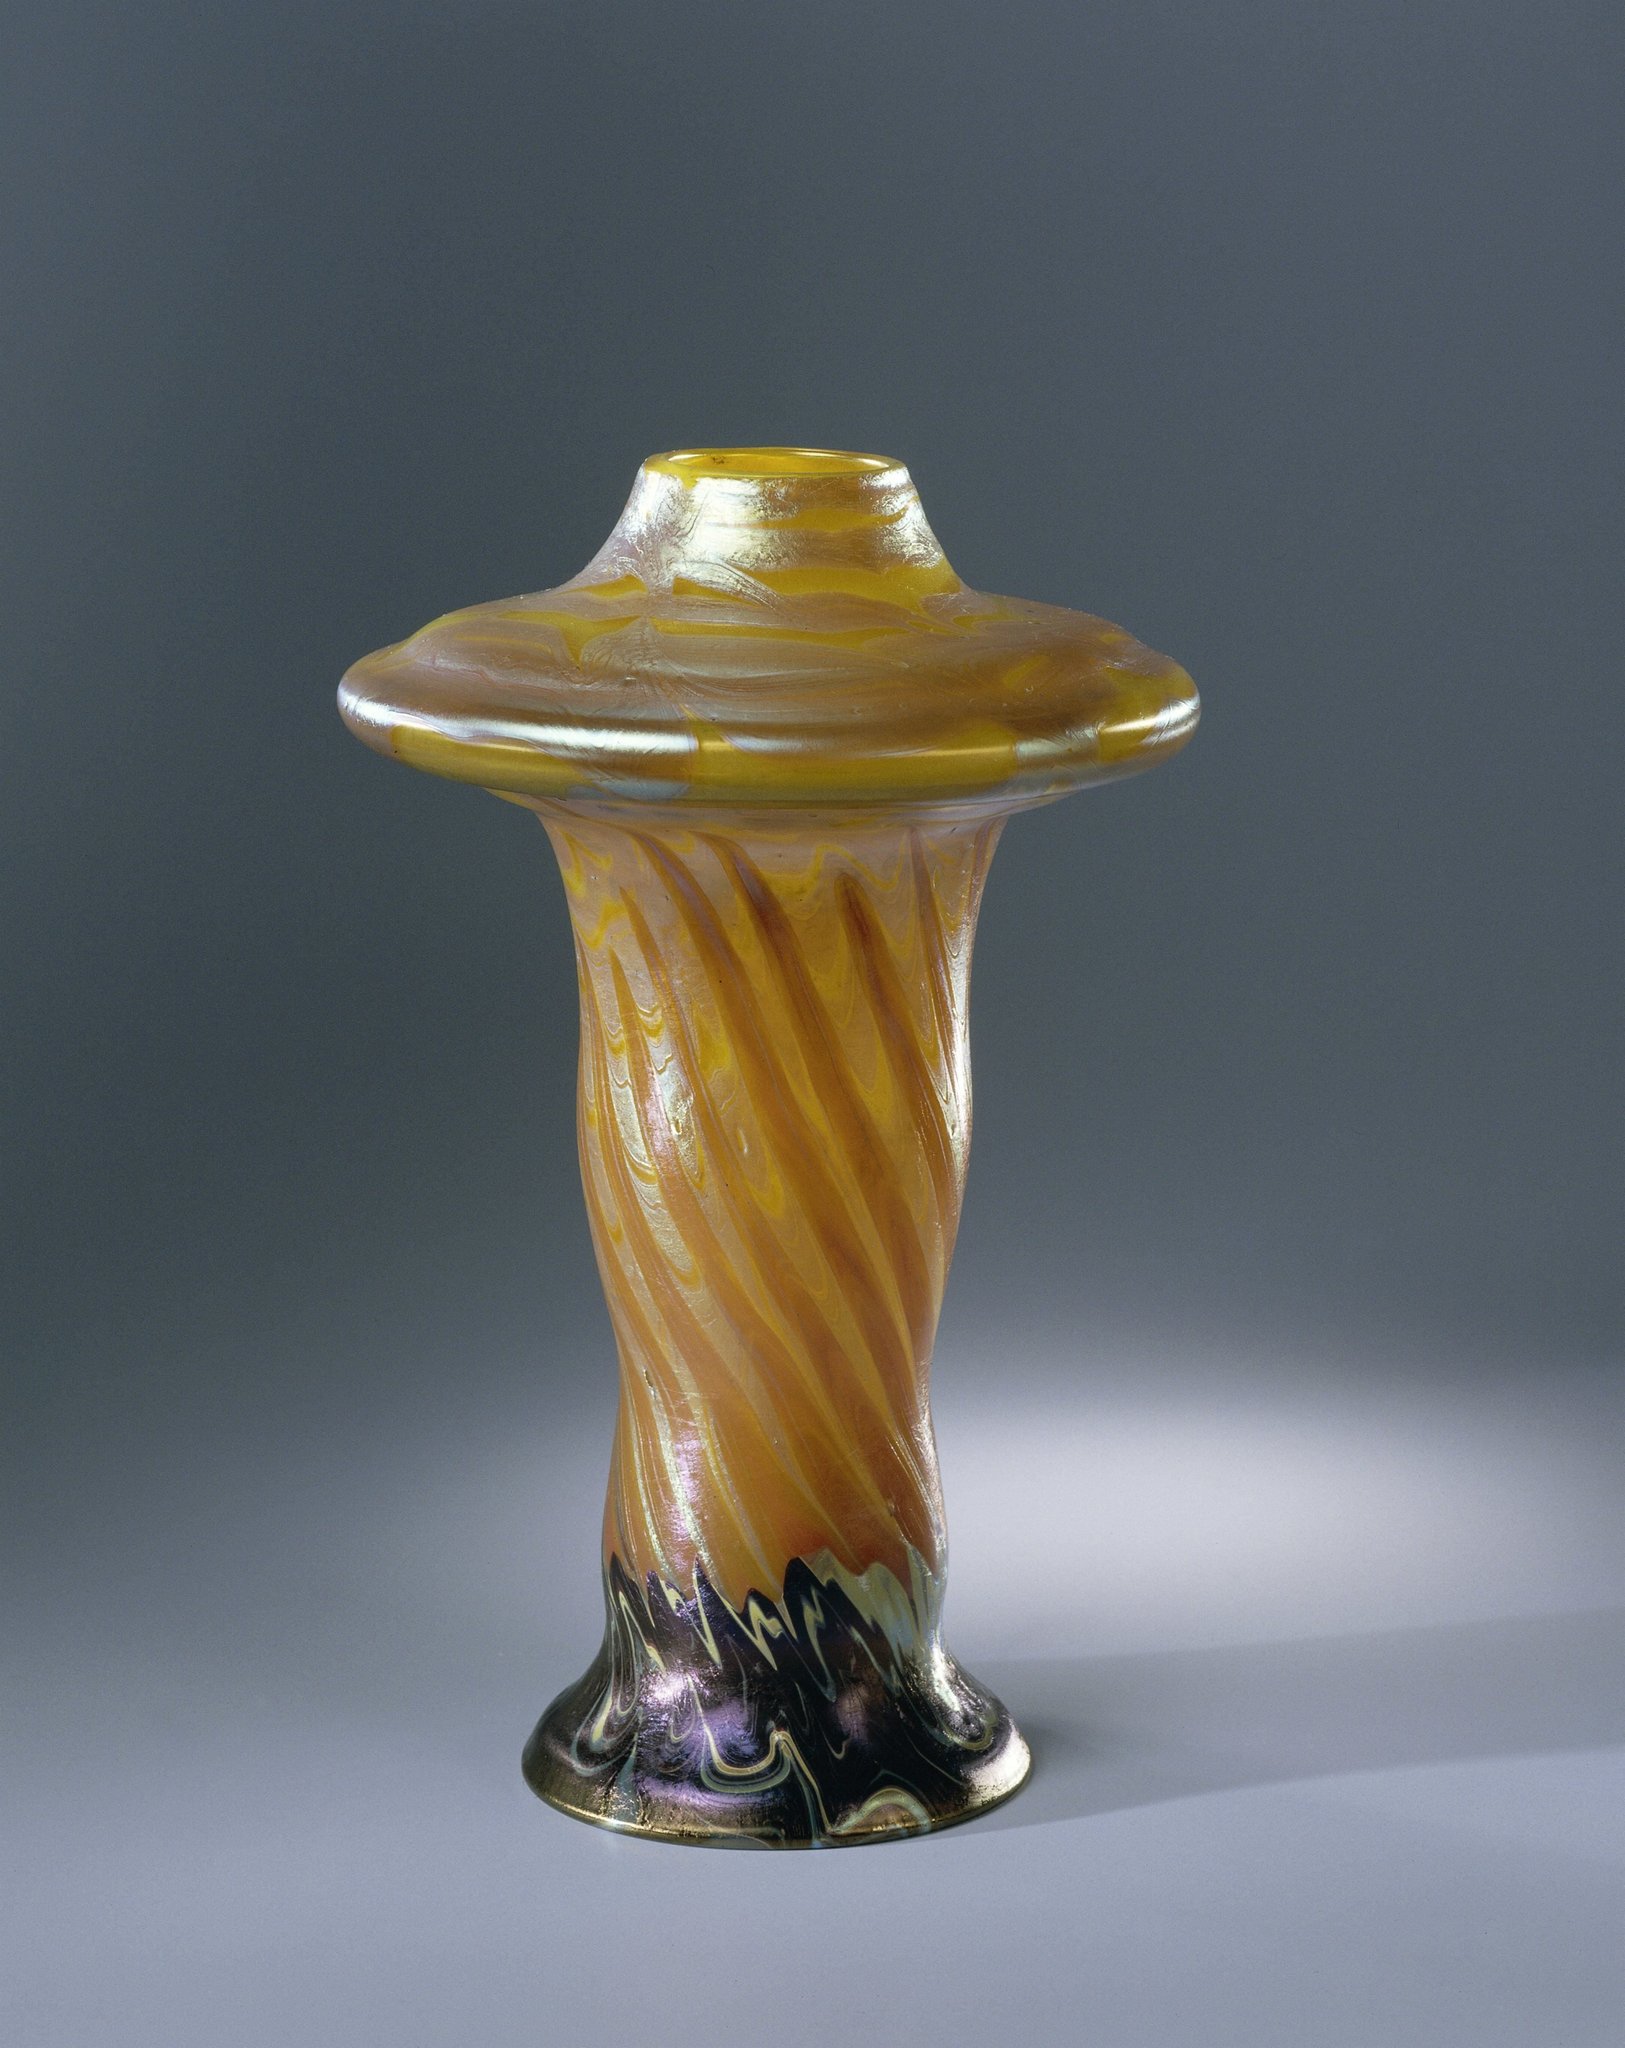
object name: vase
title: Vaas met ingewalste, zilverachtige gekamde draden en een zilverkleurige irisering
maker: franz hofstötter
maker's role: painter, sculptor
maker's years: 1871-1958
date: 1899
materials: glass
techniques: glassblowing, iridescence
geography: klostermühle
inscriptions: signature: ‘Loetz Austria’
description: Vase. Glass. Klostermühle (Bohemia), 1899, by Johann Lötz Witwe.